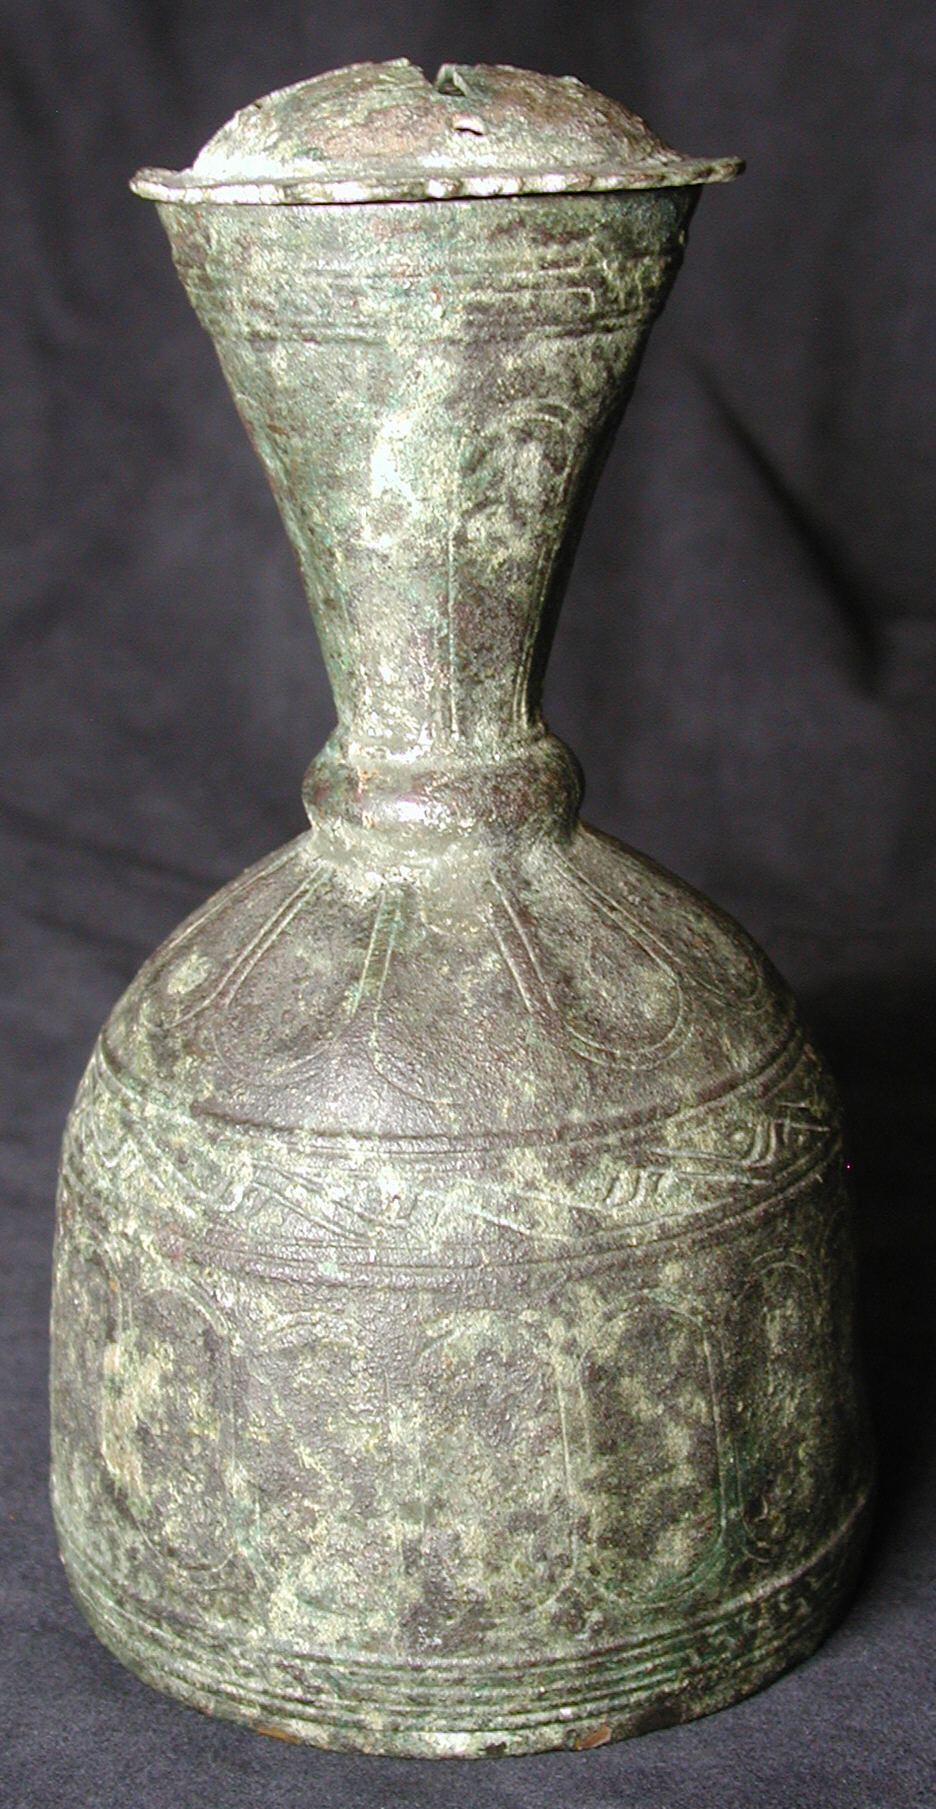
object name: bottle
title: Metal Bottle with Faceted Design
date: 901-1100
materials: brass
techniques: casting, chasing, engraving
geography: iran